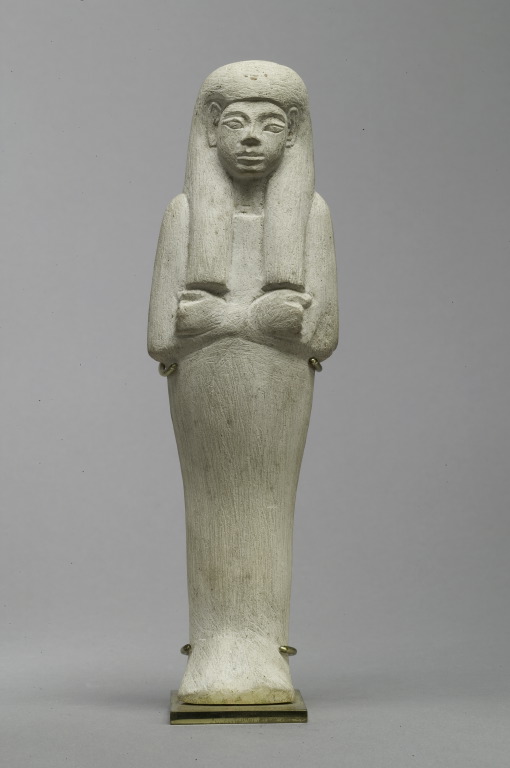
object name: shabti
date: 1279-1213 BCE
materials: limestone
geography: egypt